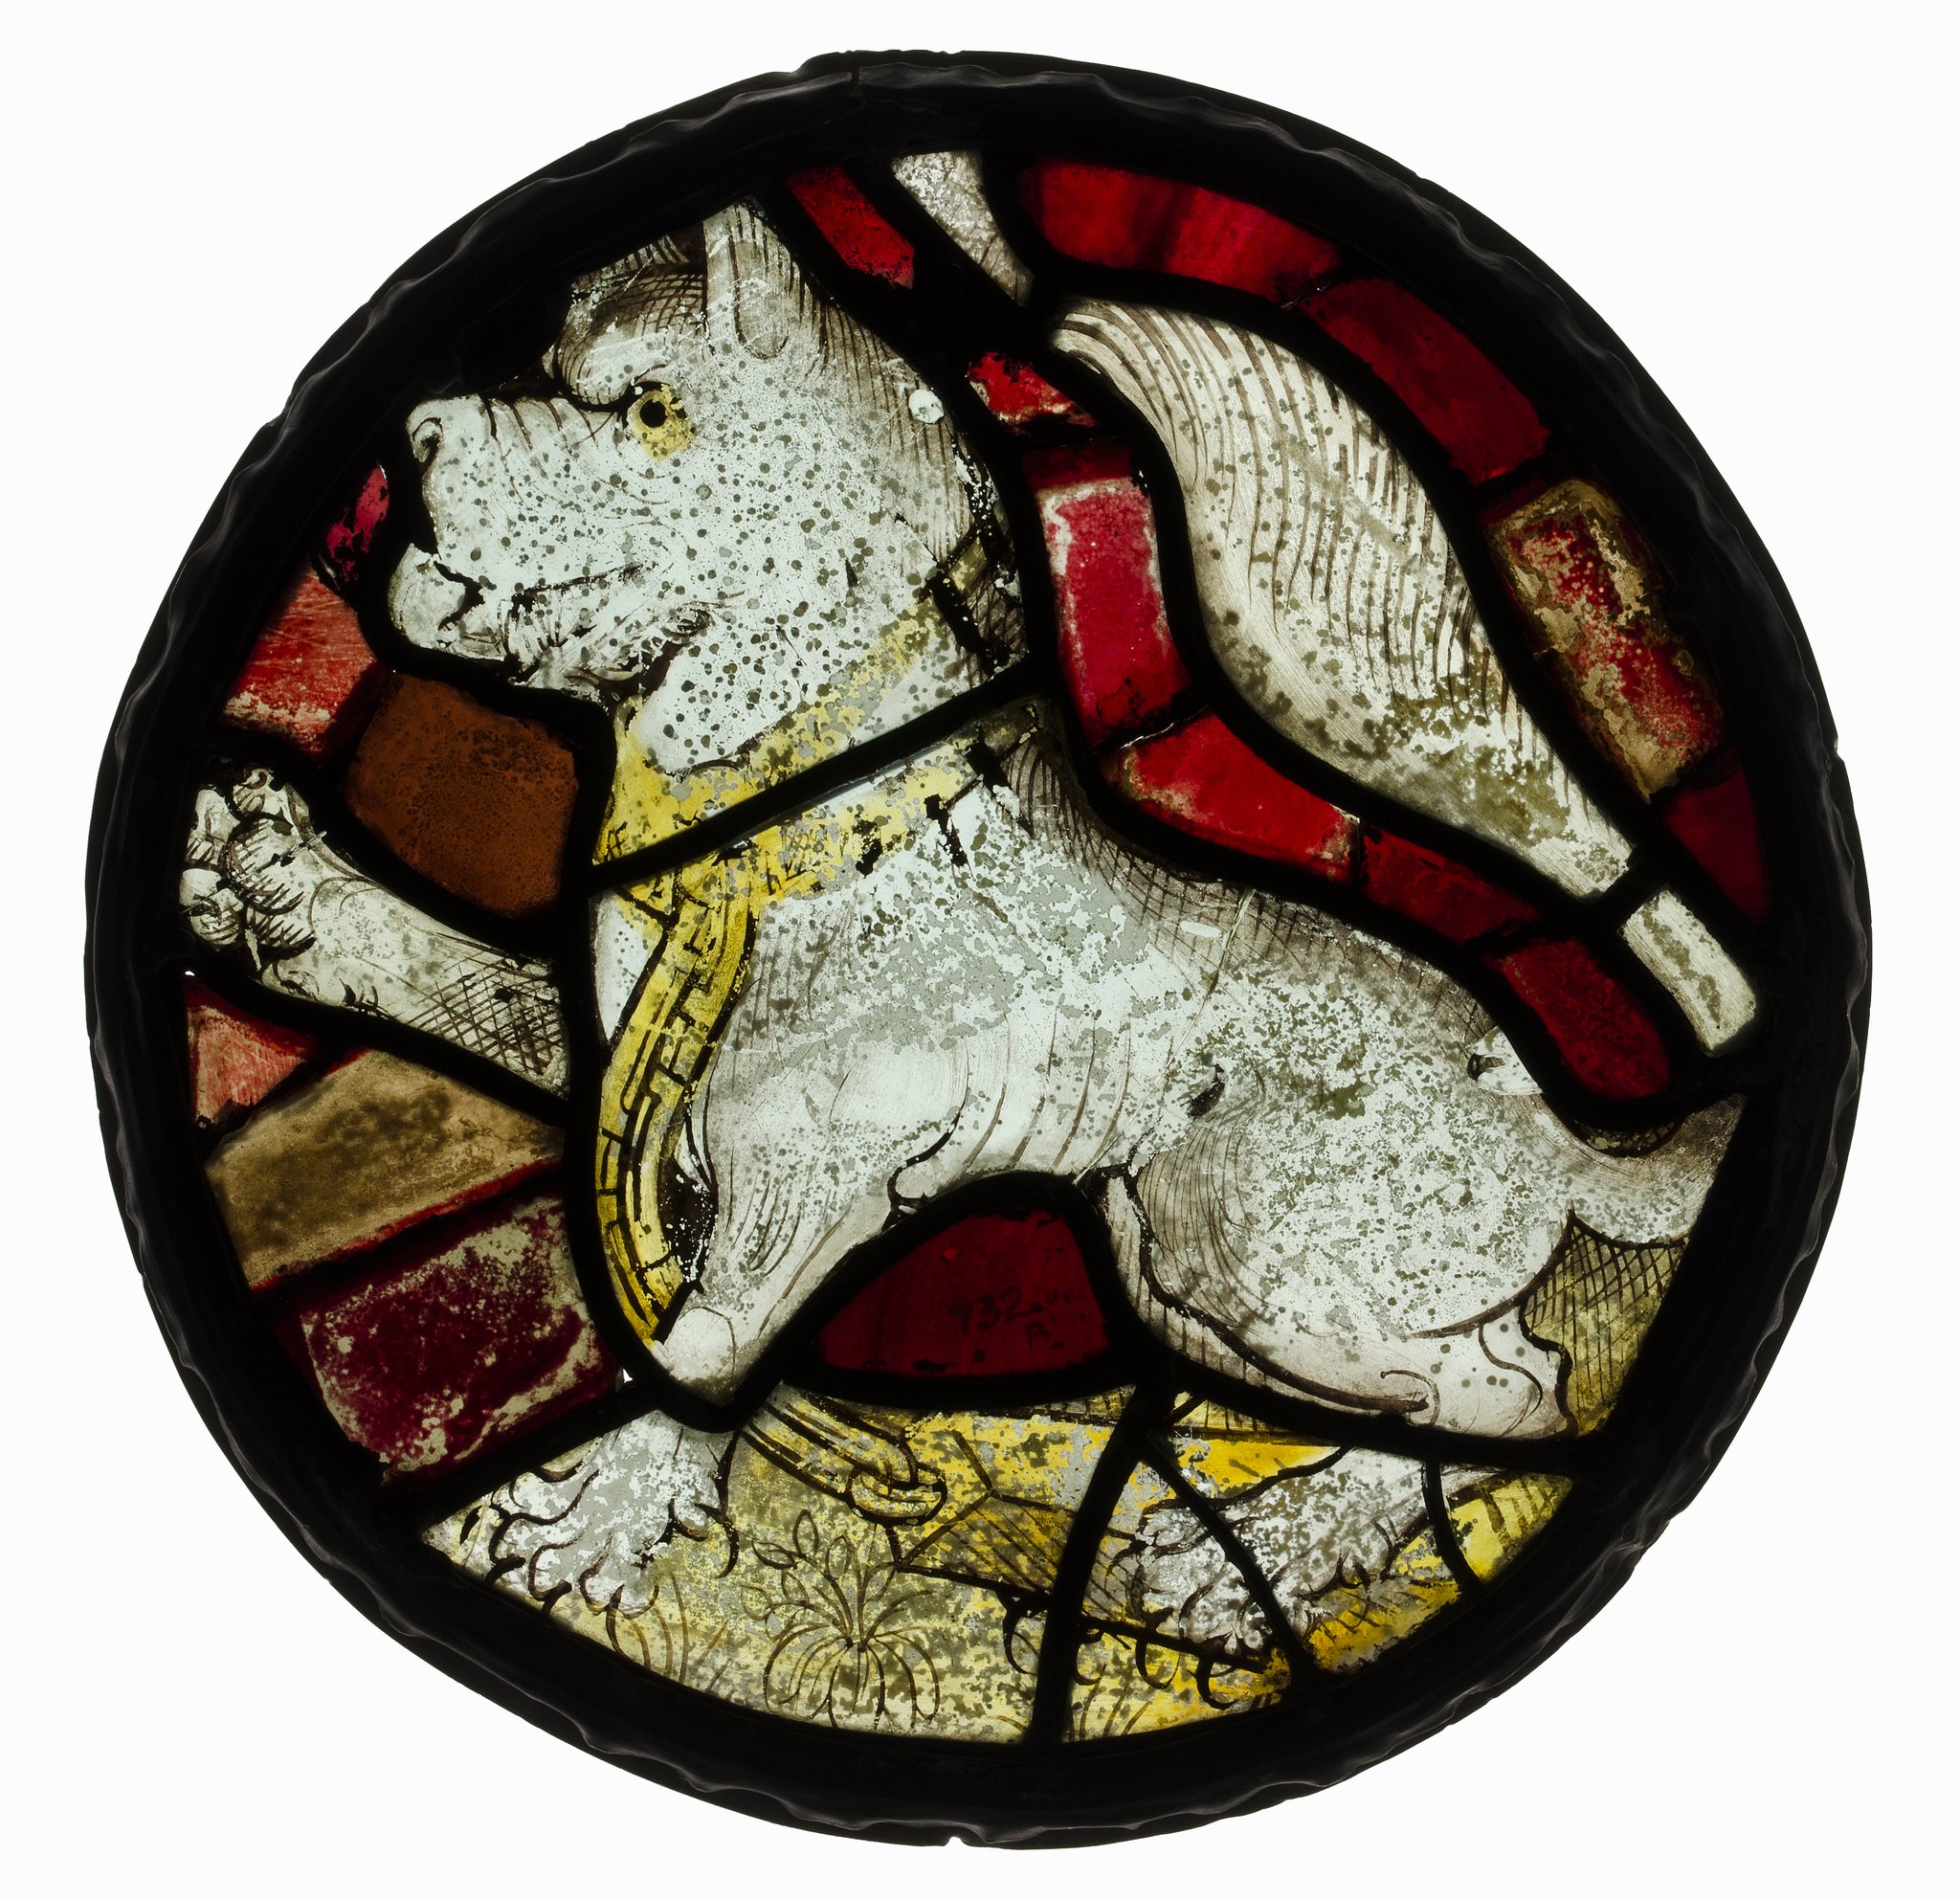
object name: roundel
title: Badge of the Fiennes Family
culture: british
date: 1450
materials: glass, metal, paint